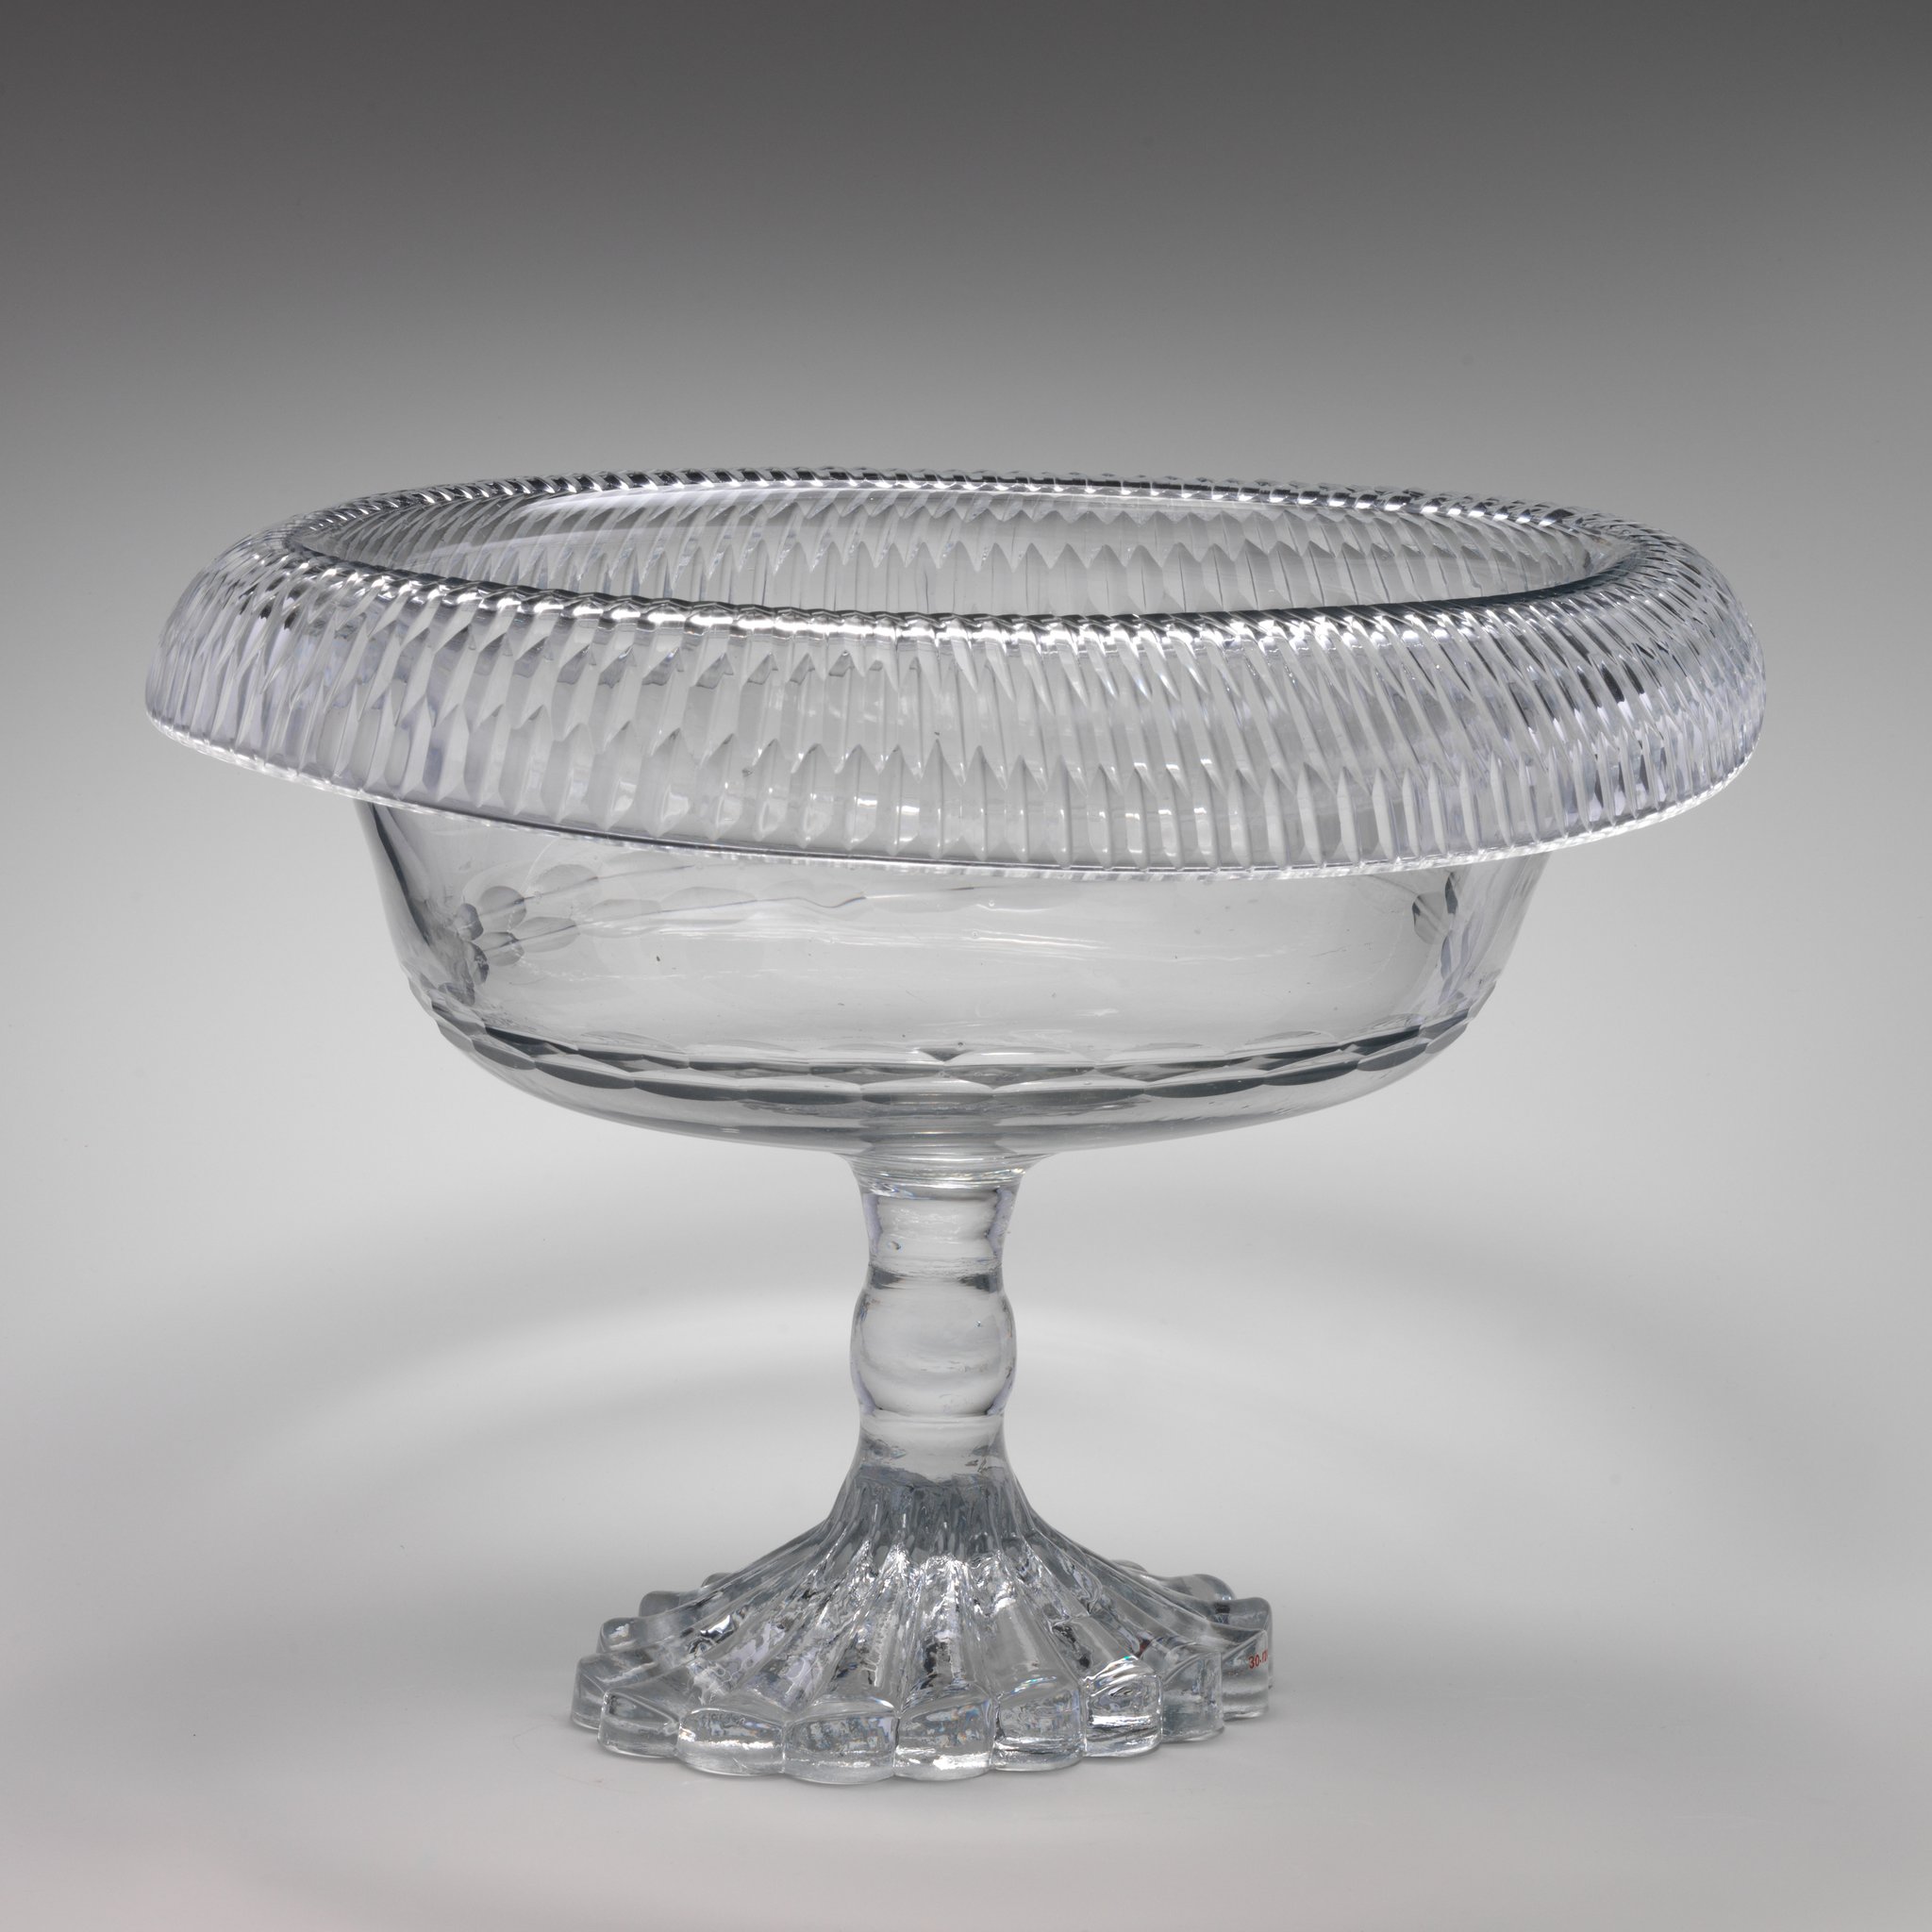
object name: fruit bowl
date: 1790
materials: glass